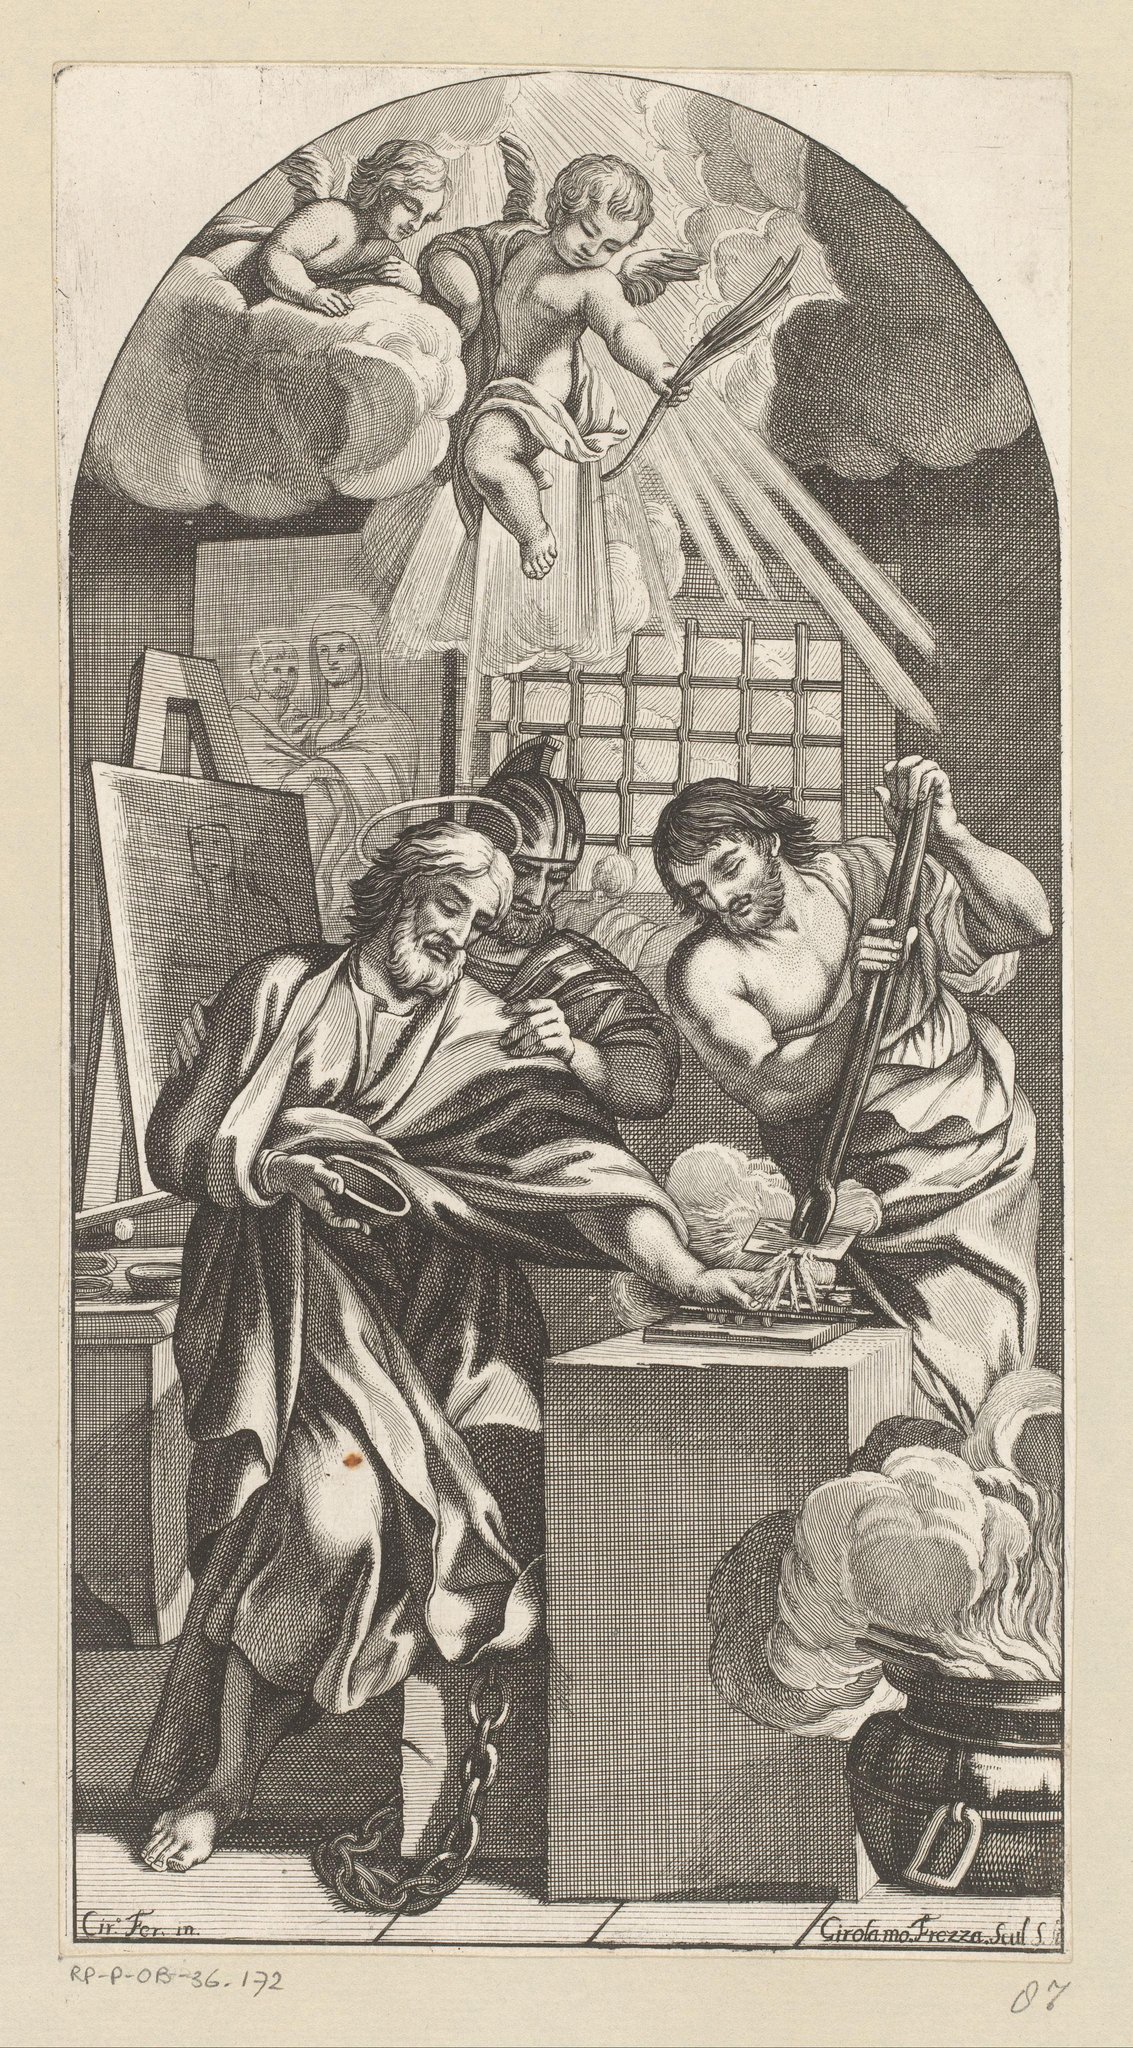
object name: print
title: Schilder en smid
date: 1686-1748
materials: paper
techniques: engraving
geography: italy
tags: workshop, studio ~ painter, smith, blacksmith, cupids: 'amores', 'amoretti', 'putti', working situations ~ painter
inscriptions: collector's mark: Lugt 240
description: Een heilige schilder, een soldaat en een smid rond een blok waar de penselen van de schilder worden verhit. Boven engelen. Op de achtergrond links twee schildersdoeken met voorstellingen van Maria met Kind.